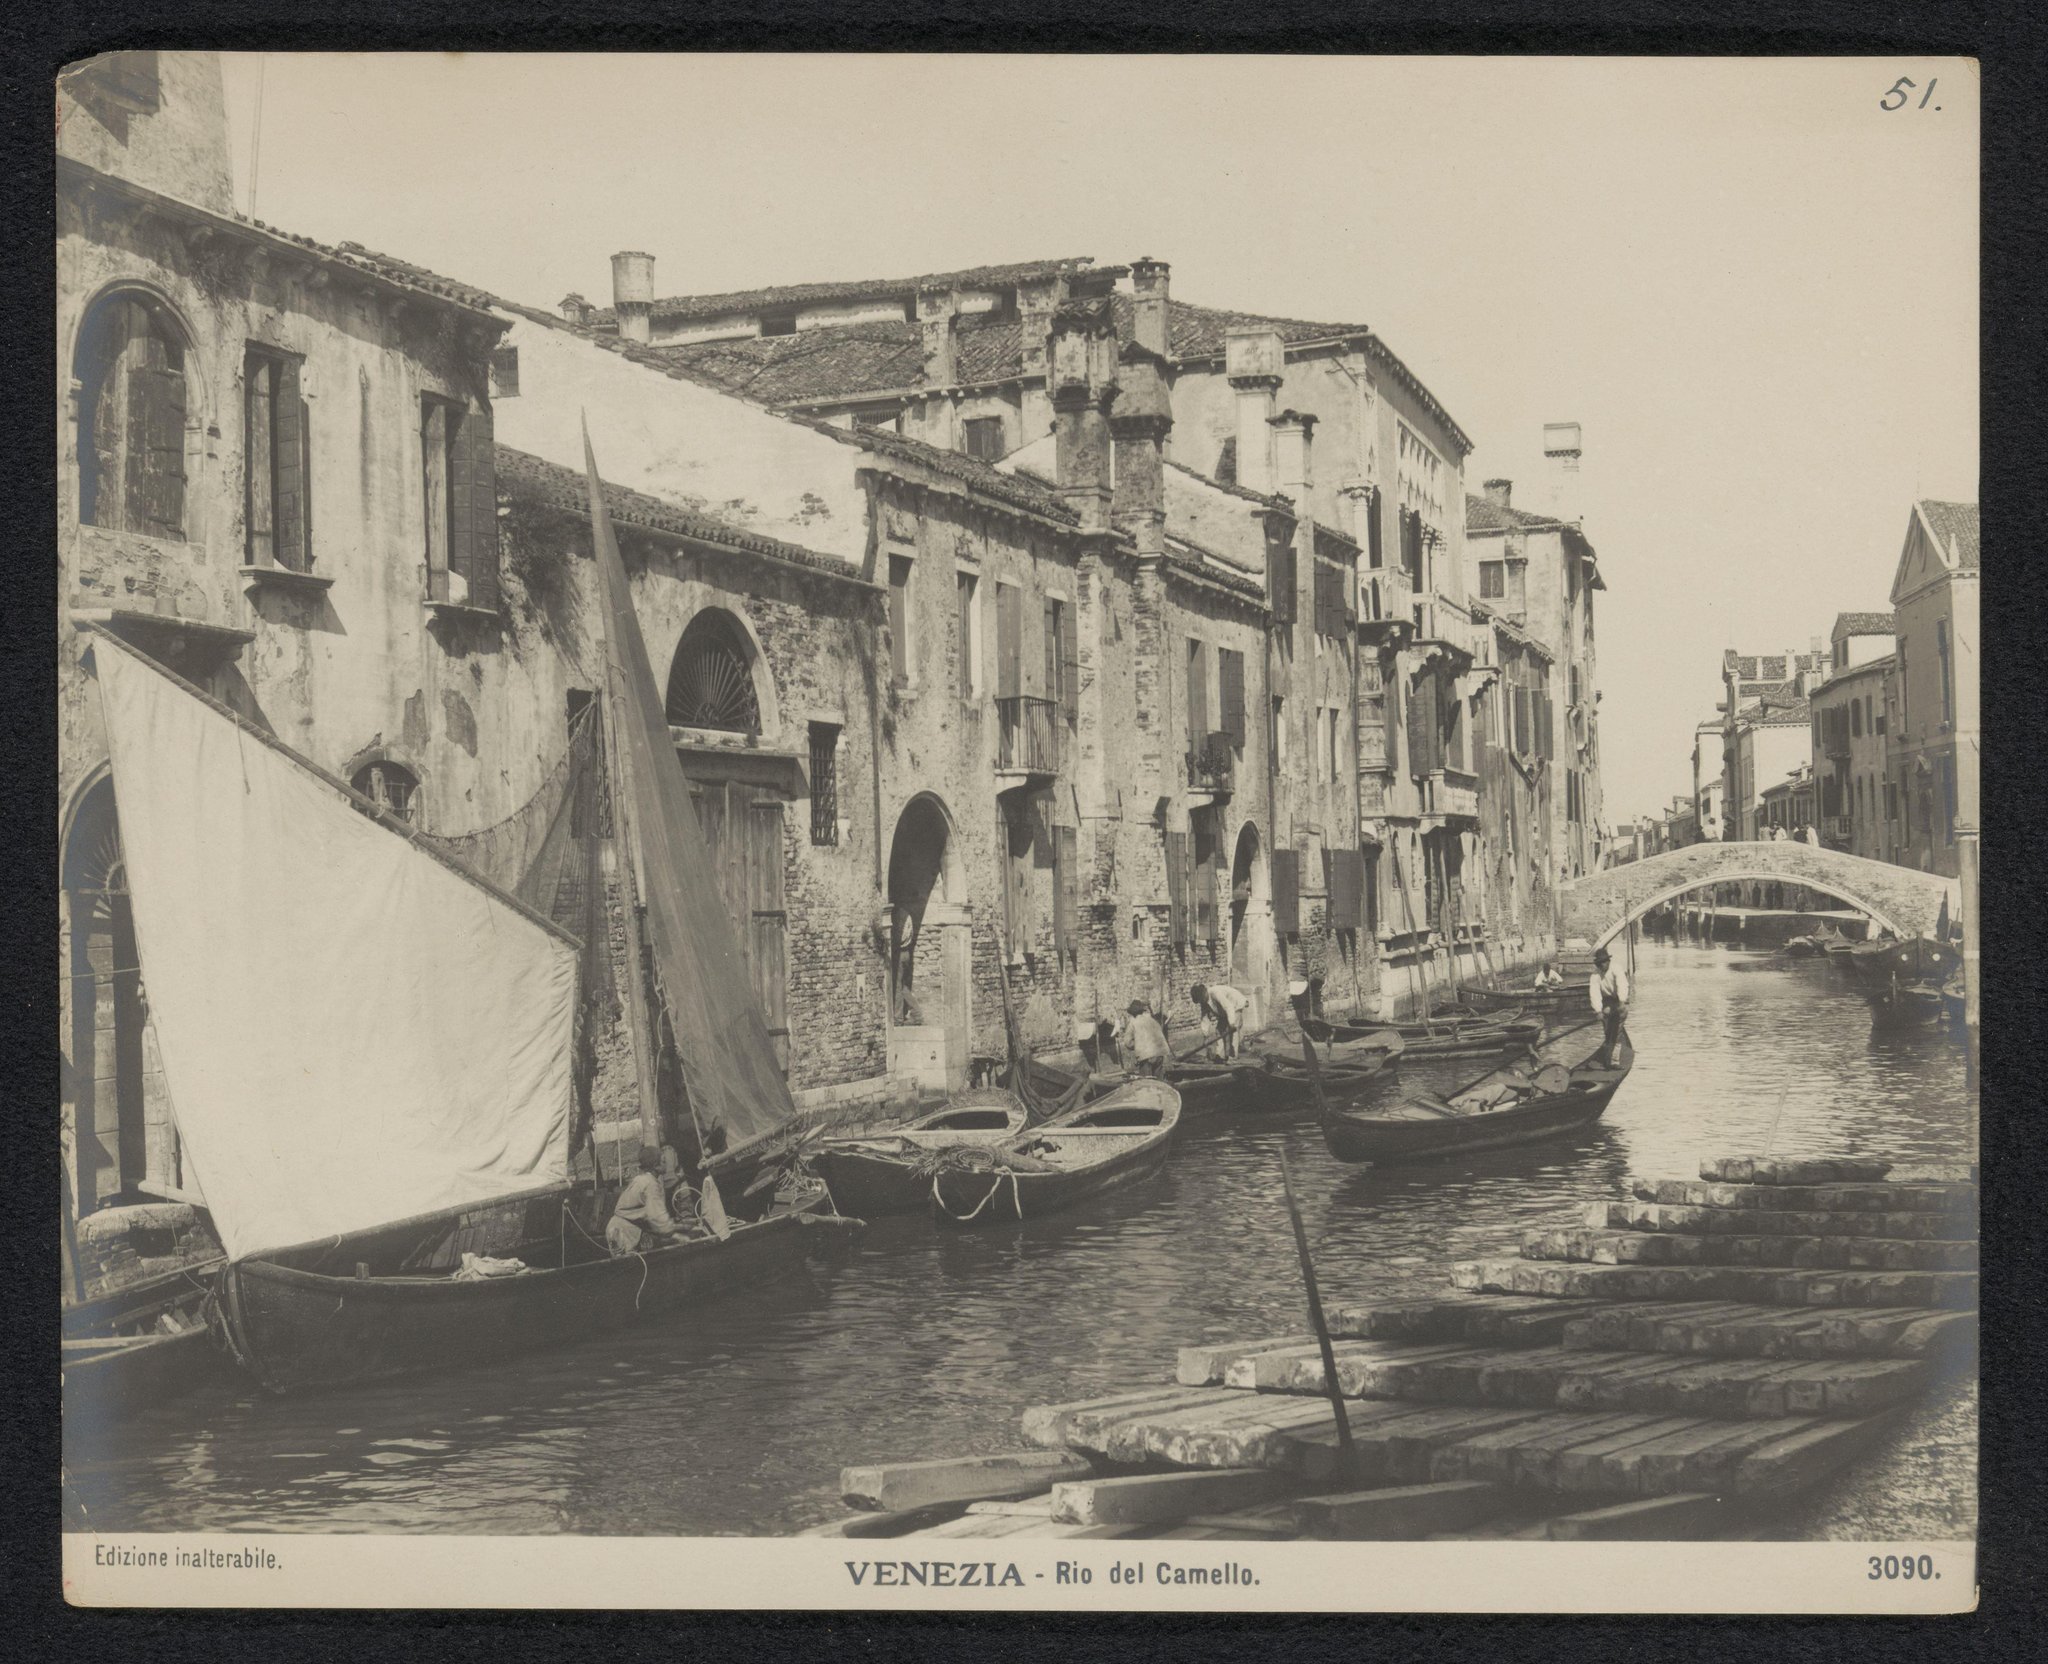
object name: photograph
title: Gezicht op de Rio del Camello te Venetië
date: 1900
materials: cardboard, photographic support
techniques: gelatin silver print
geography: venice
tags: canal, façade (of house or building), gondola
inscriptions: number: ‘51.’, number: ‘3090.’